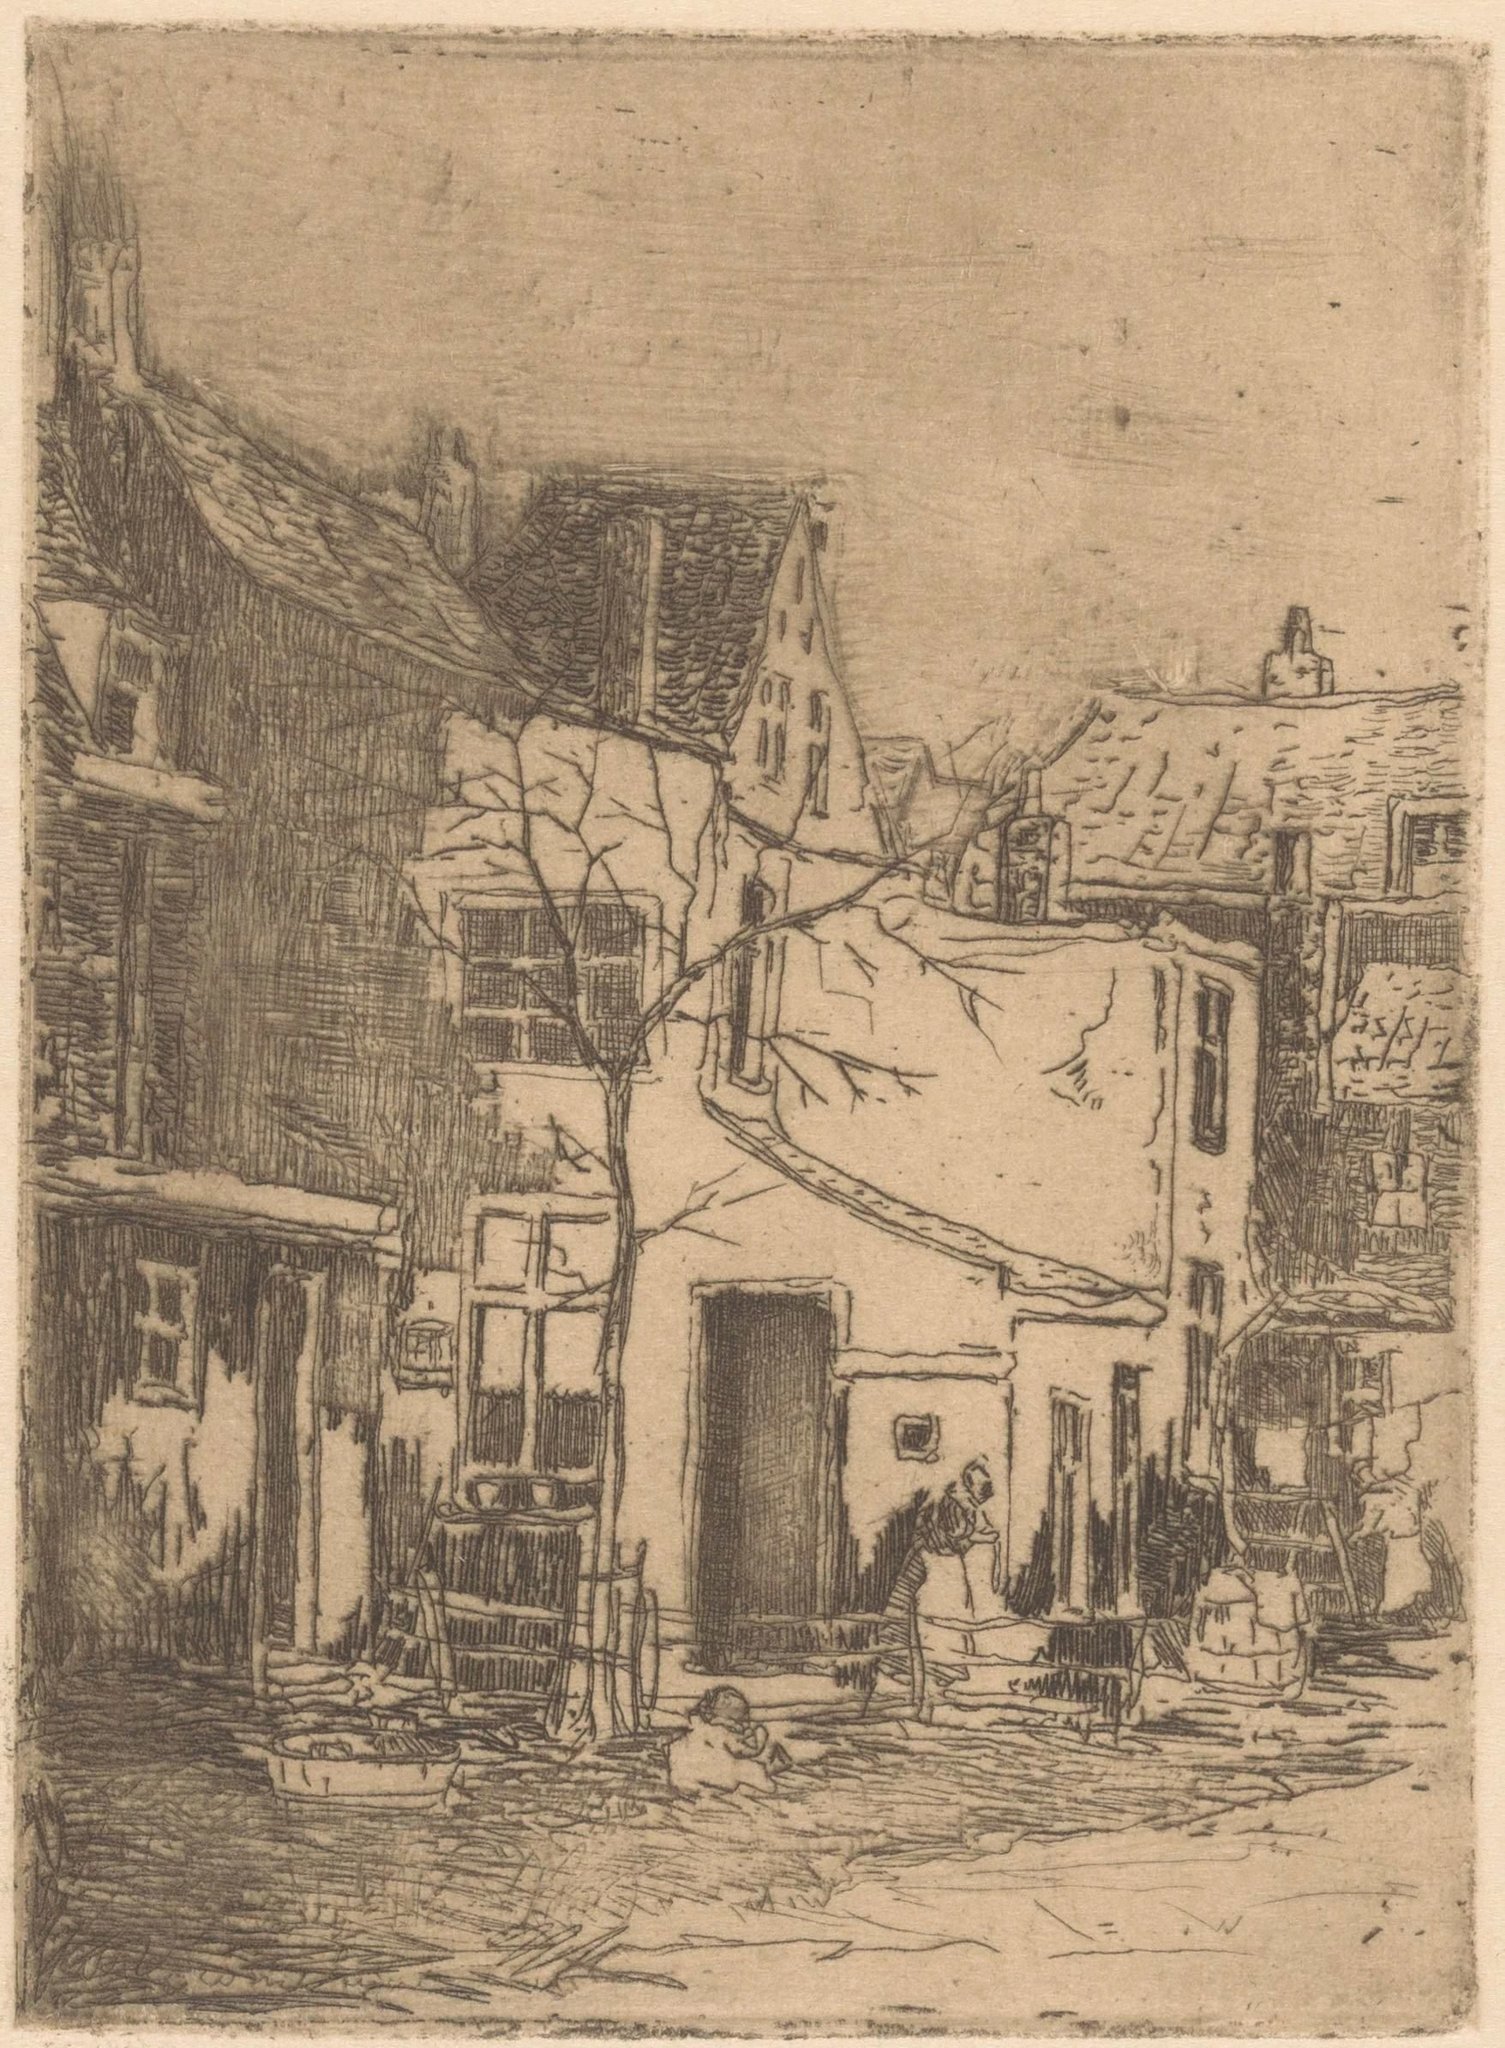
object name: print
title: Huizen in Rijswijk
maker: willem adrianus grondhout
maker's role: draughtsman, painter, print maker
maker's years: 1878-1934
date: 1888-1934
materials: paper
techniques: etching, intaglio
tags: civic architecture; edifices; dwellings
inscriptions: collector's mark: Lugt 2228